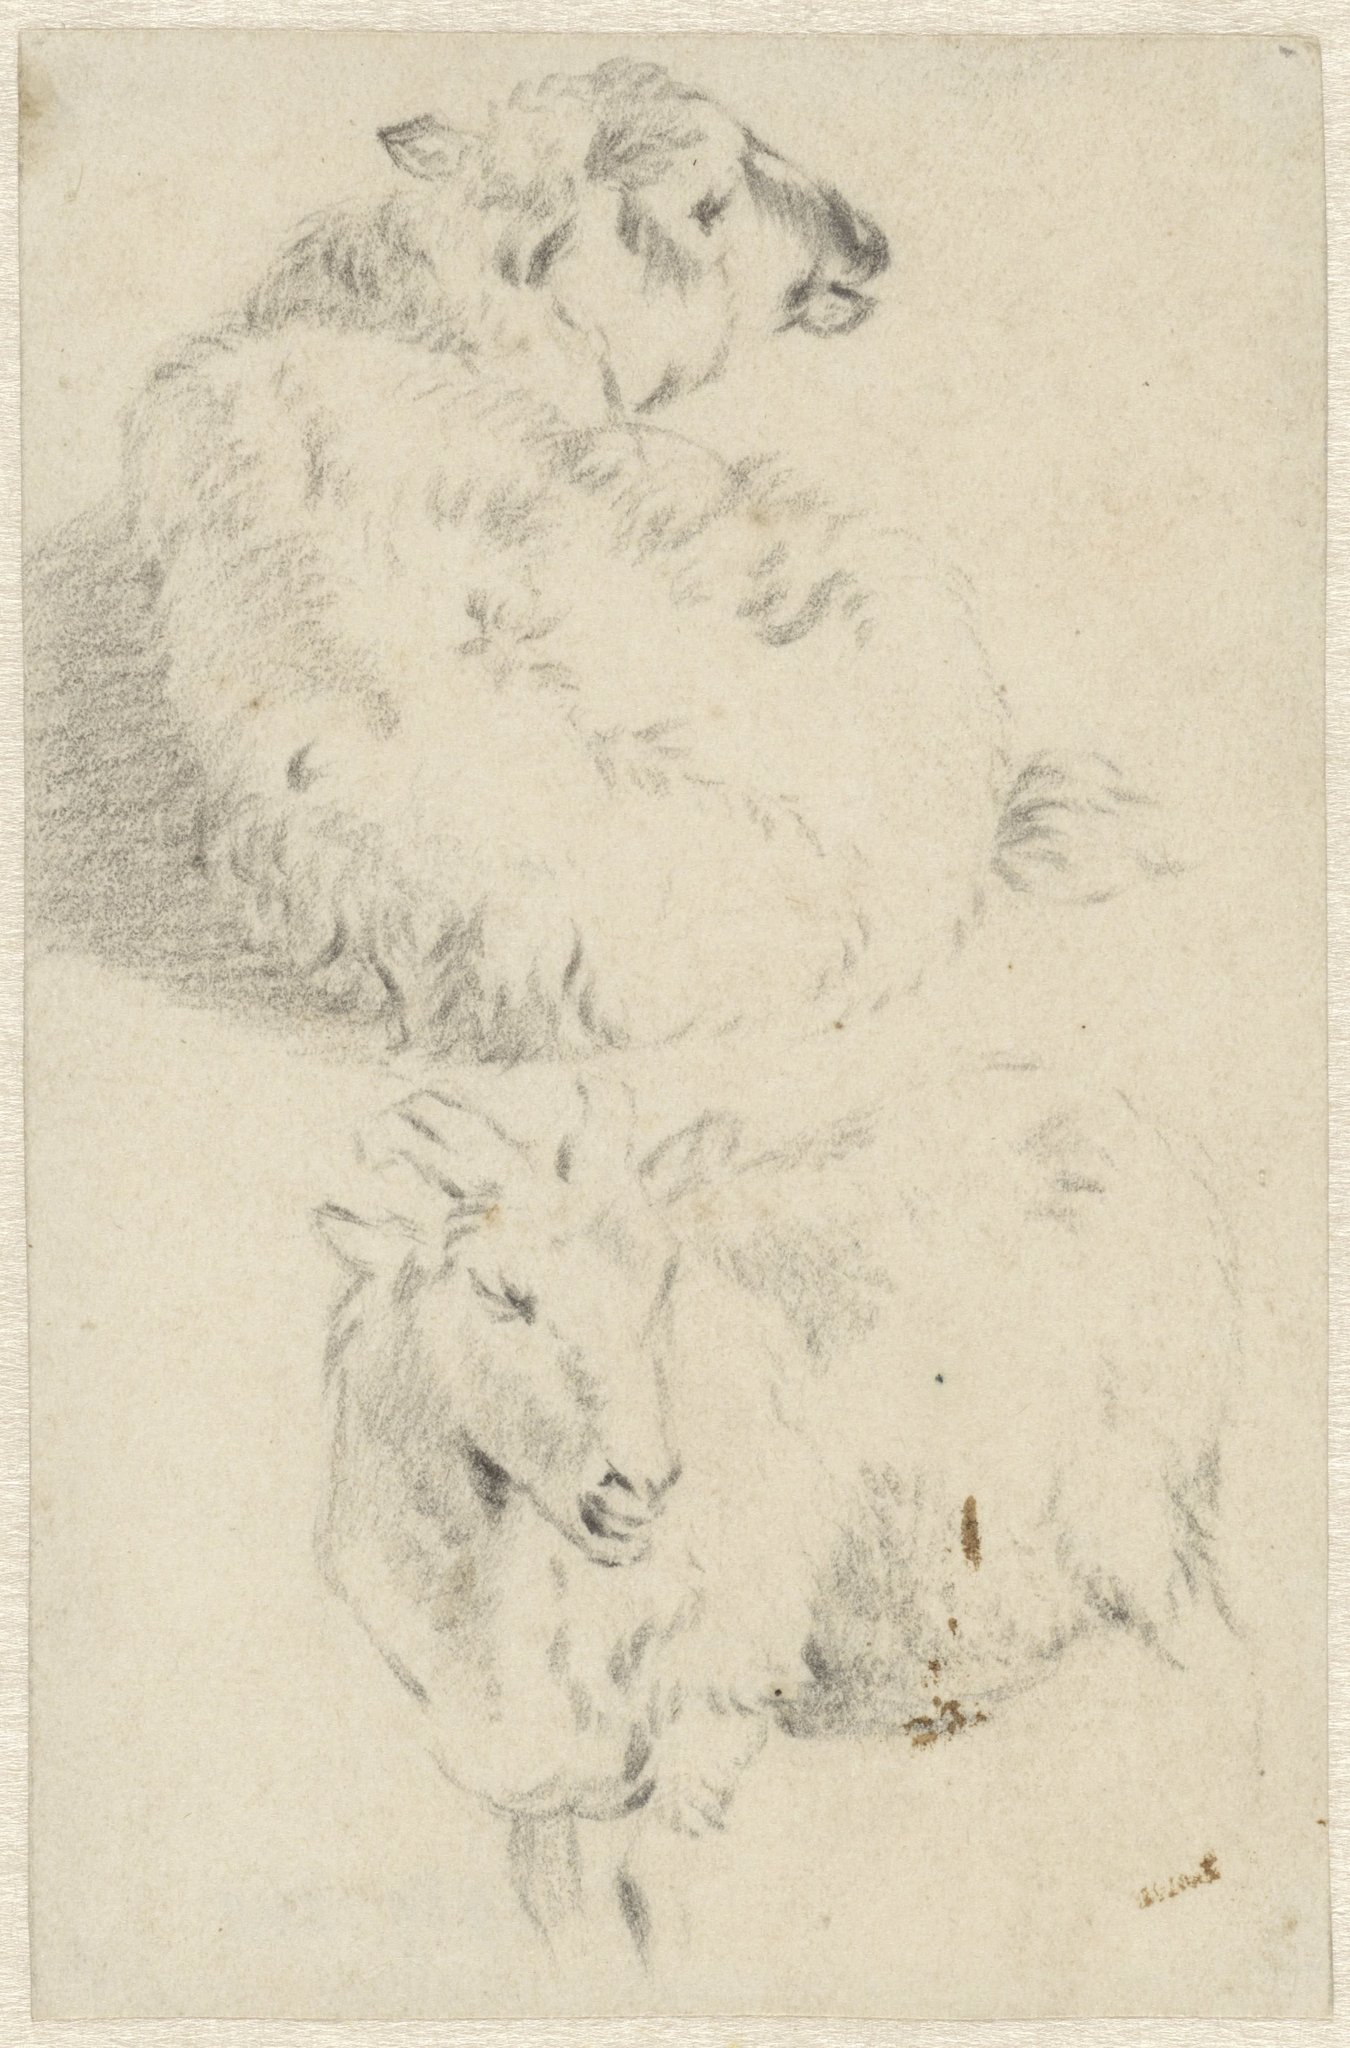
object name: drawing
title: Twee studies van een schaap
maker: abraham krayestein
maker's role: draughtsman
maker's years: 1793-1855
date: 1803-1855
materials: chalk, paper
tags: sheep